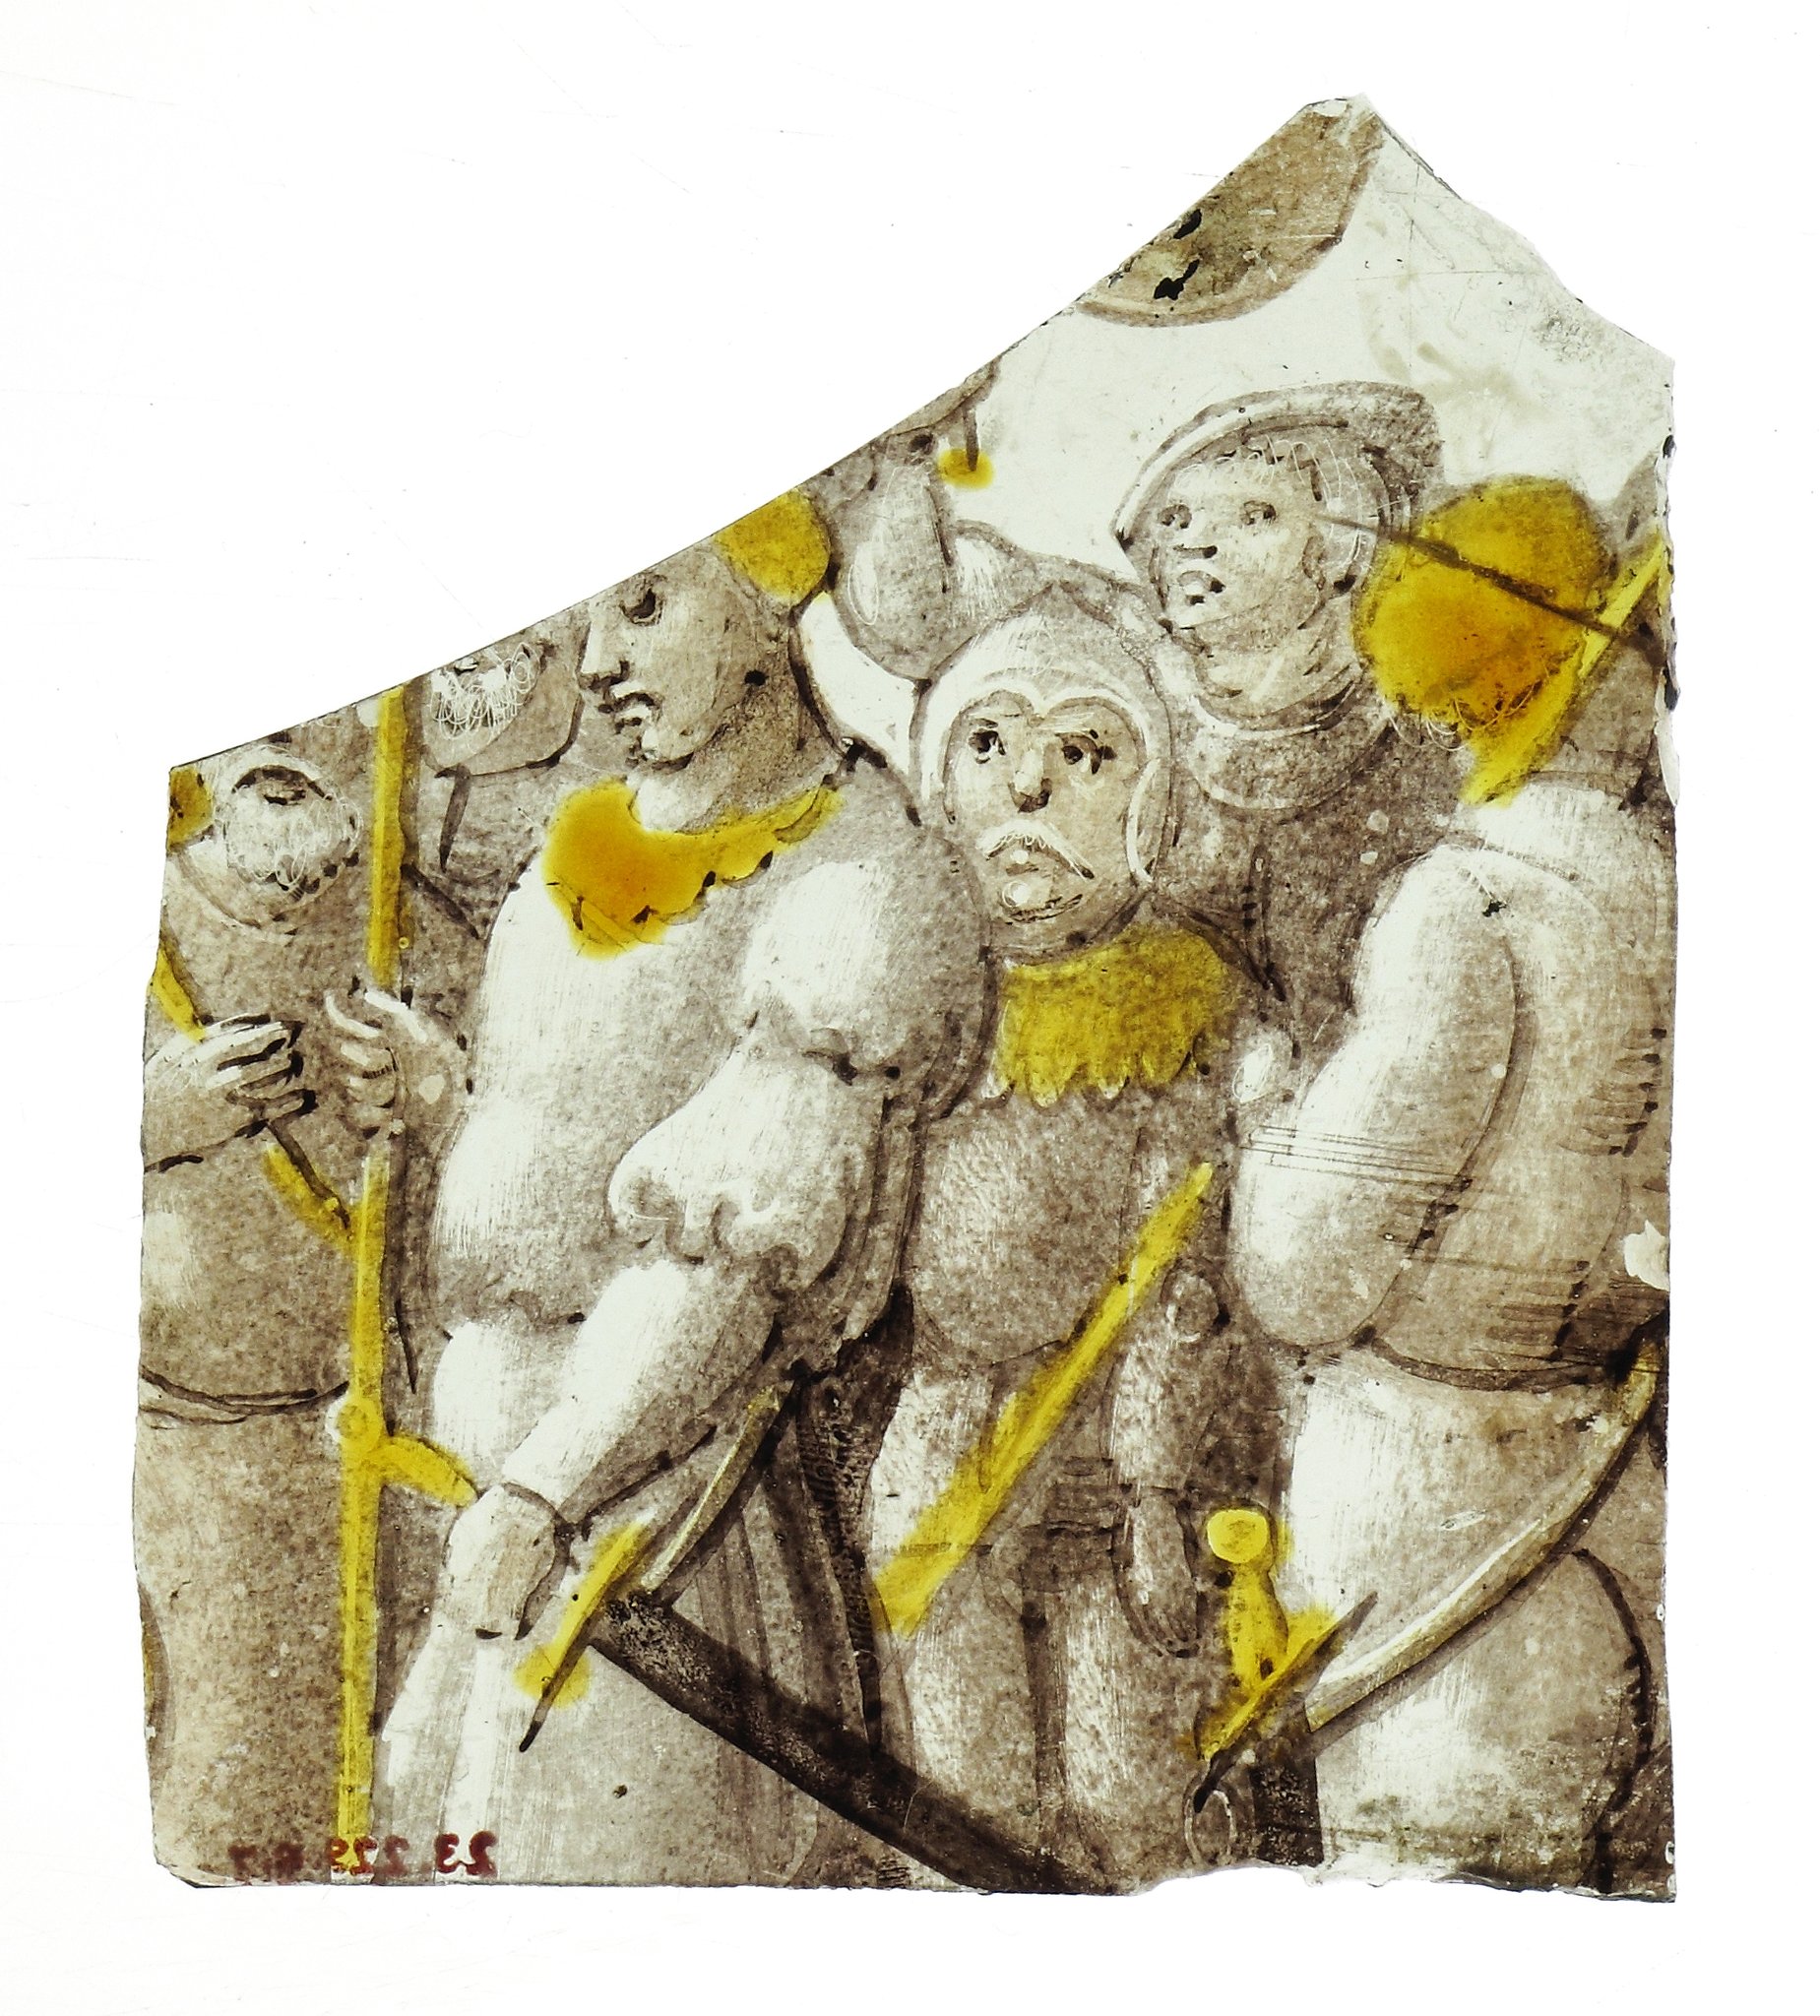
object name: fragment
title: Glass Fragment with Soldiers in Armor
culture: french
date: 1301-1500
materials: glass